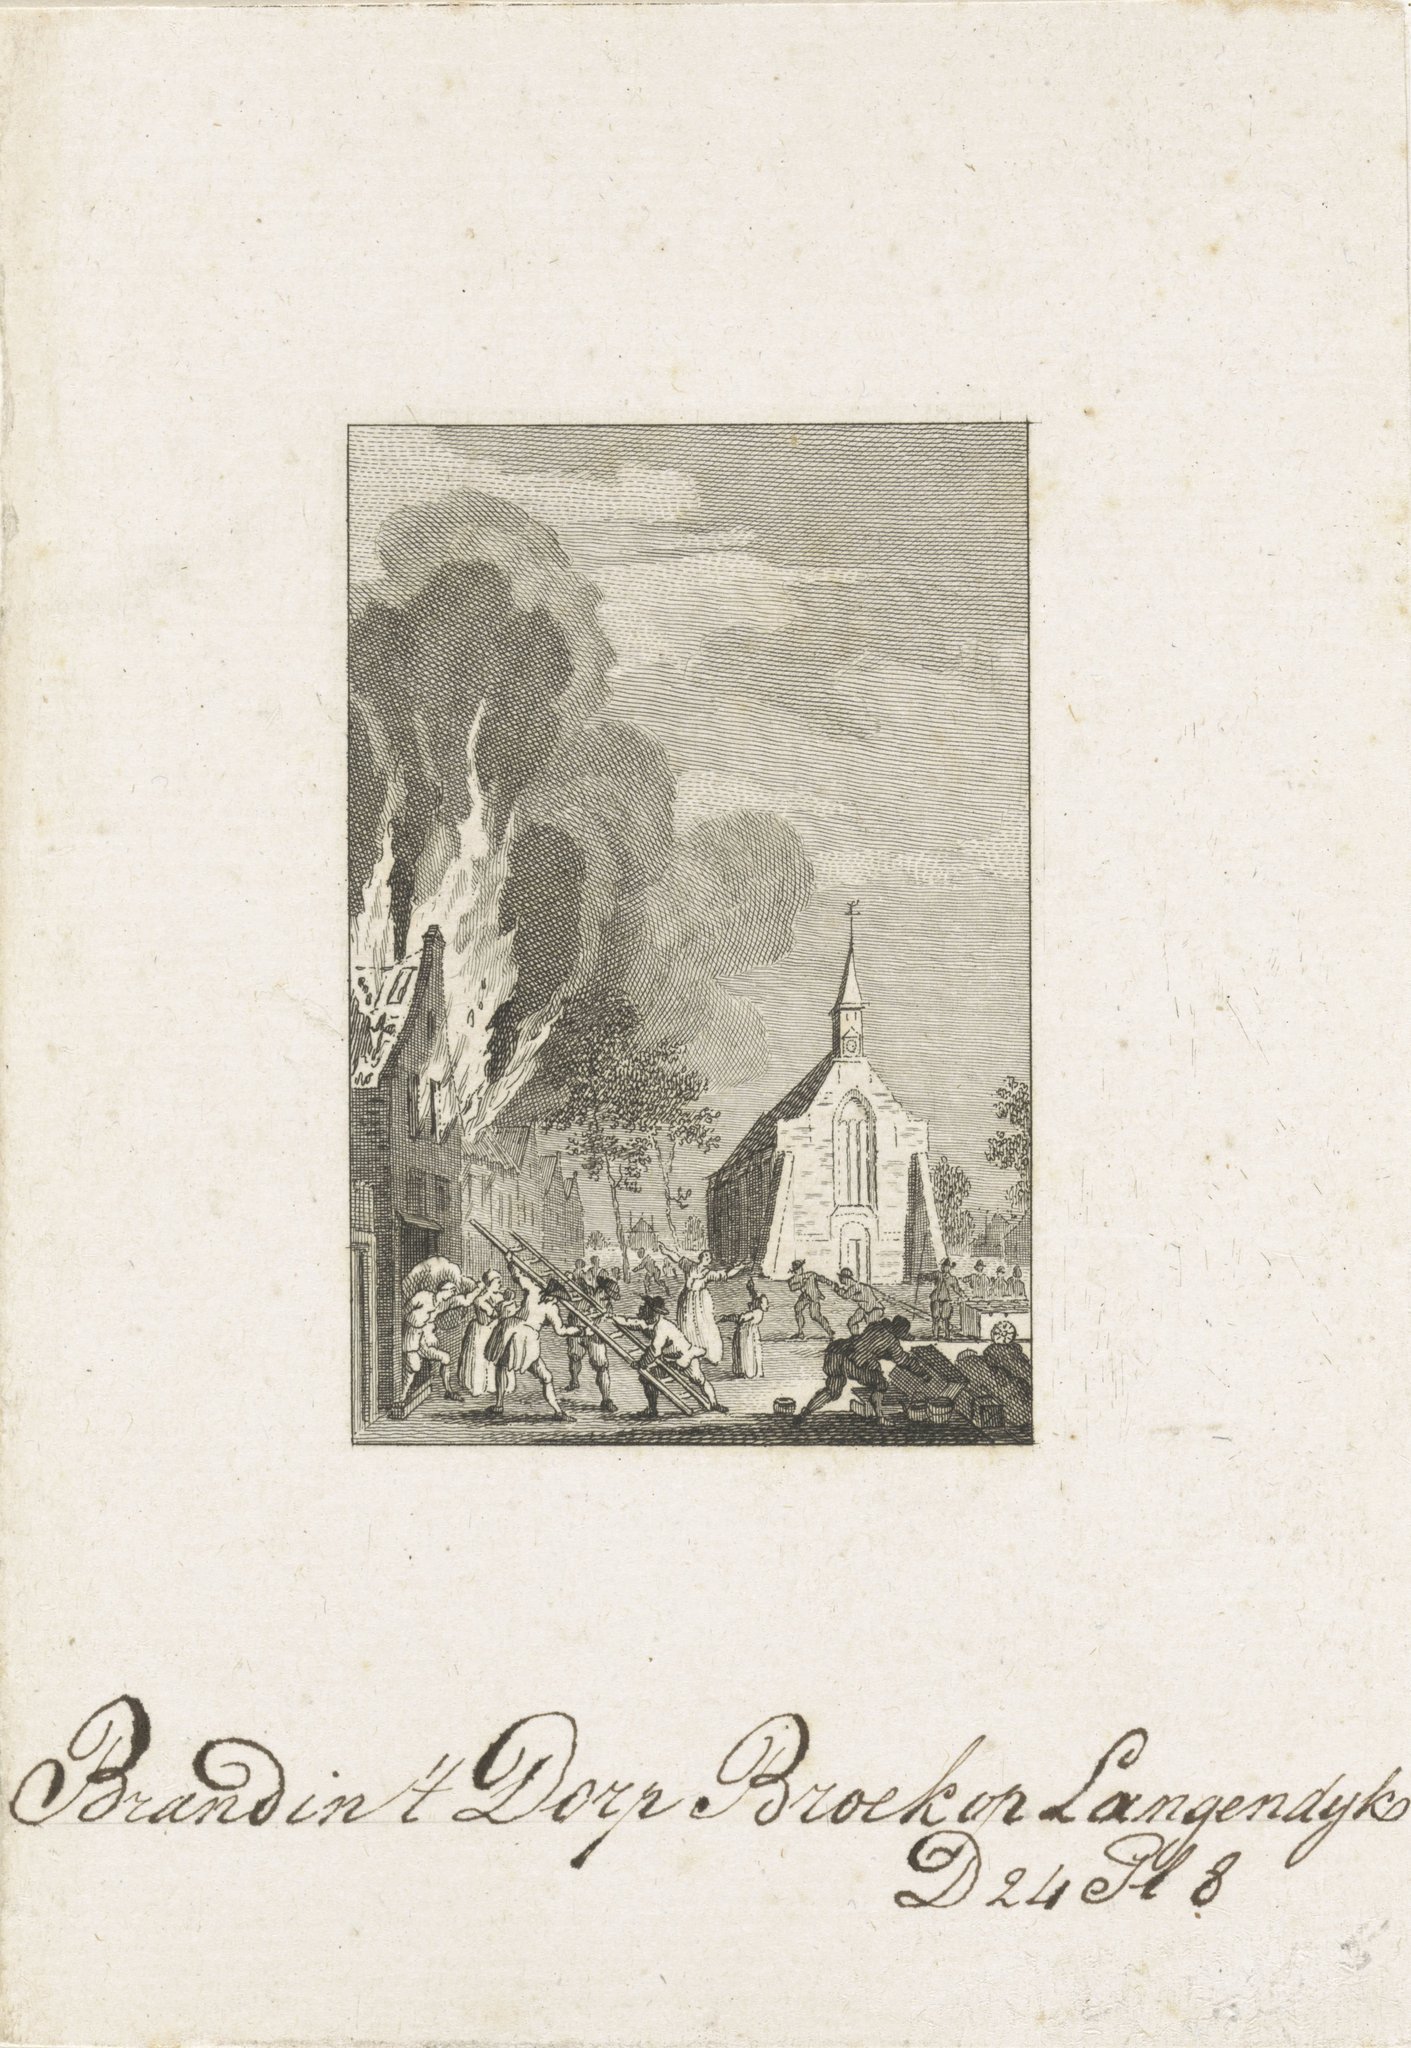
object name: print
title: Brand te Broek op Langedijk, 1793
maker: cornelis bogerts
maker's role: print maker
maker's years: 1745-1817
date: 1793-1795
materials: paper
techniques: engraving, etching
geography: northern netherlands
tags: on fire, ablaze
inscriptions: collector's mark: Lugt 2228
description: Gebruikt als illustratie in: J. Fokke, Geschiedenissen der Vereenigde Nederlanden voor de vaderlandsche jeugd, Johannes Allart, Amsterdam 1783-1795, 25 delen, dl. 24, pl. 8.